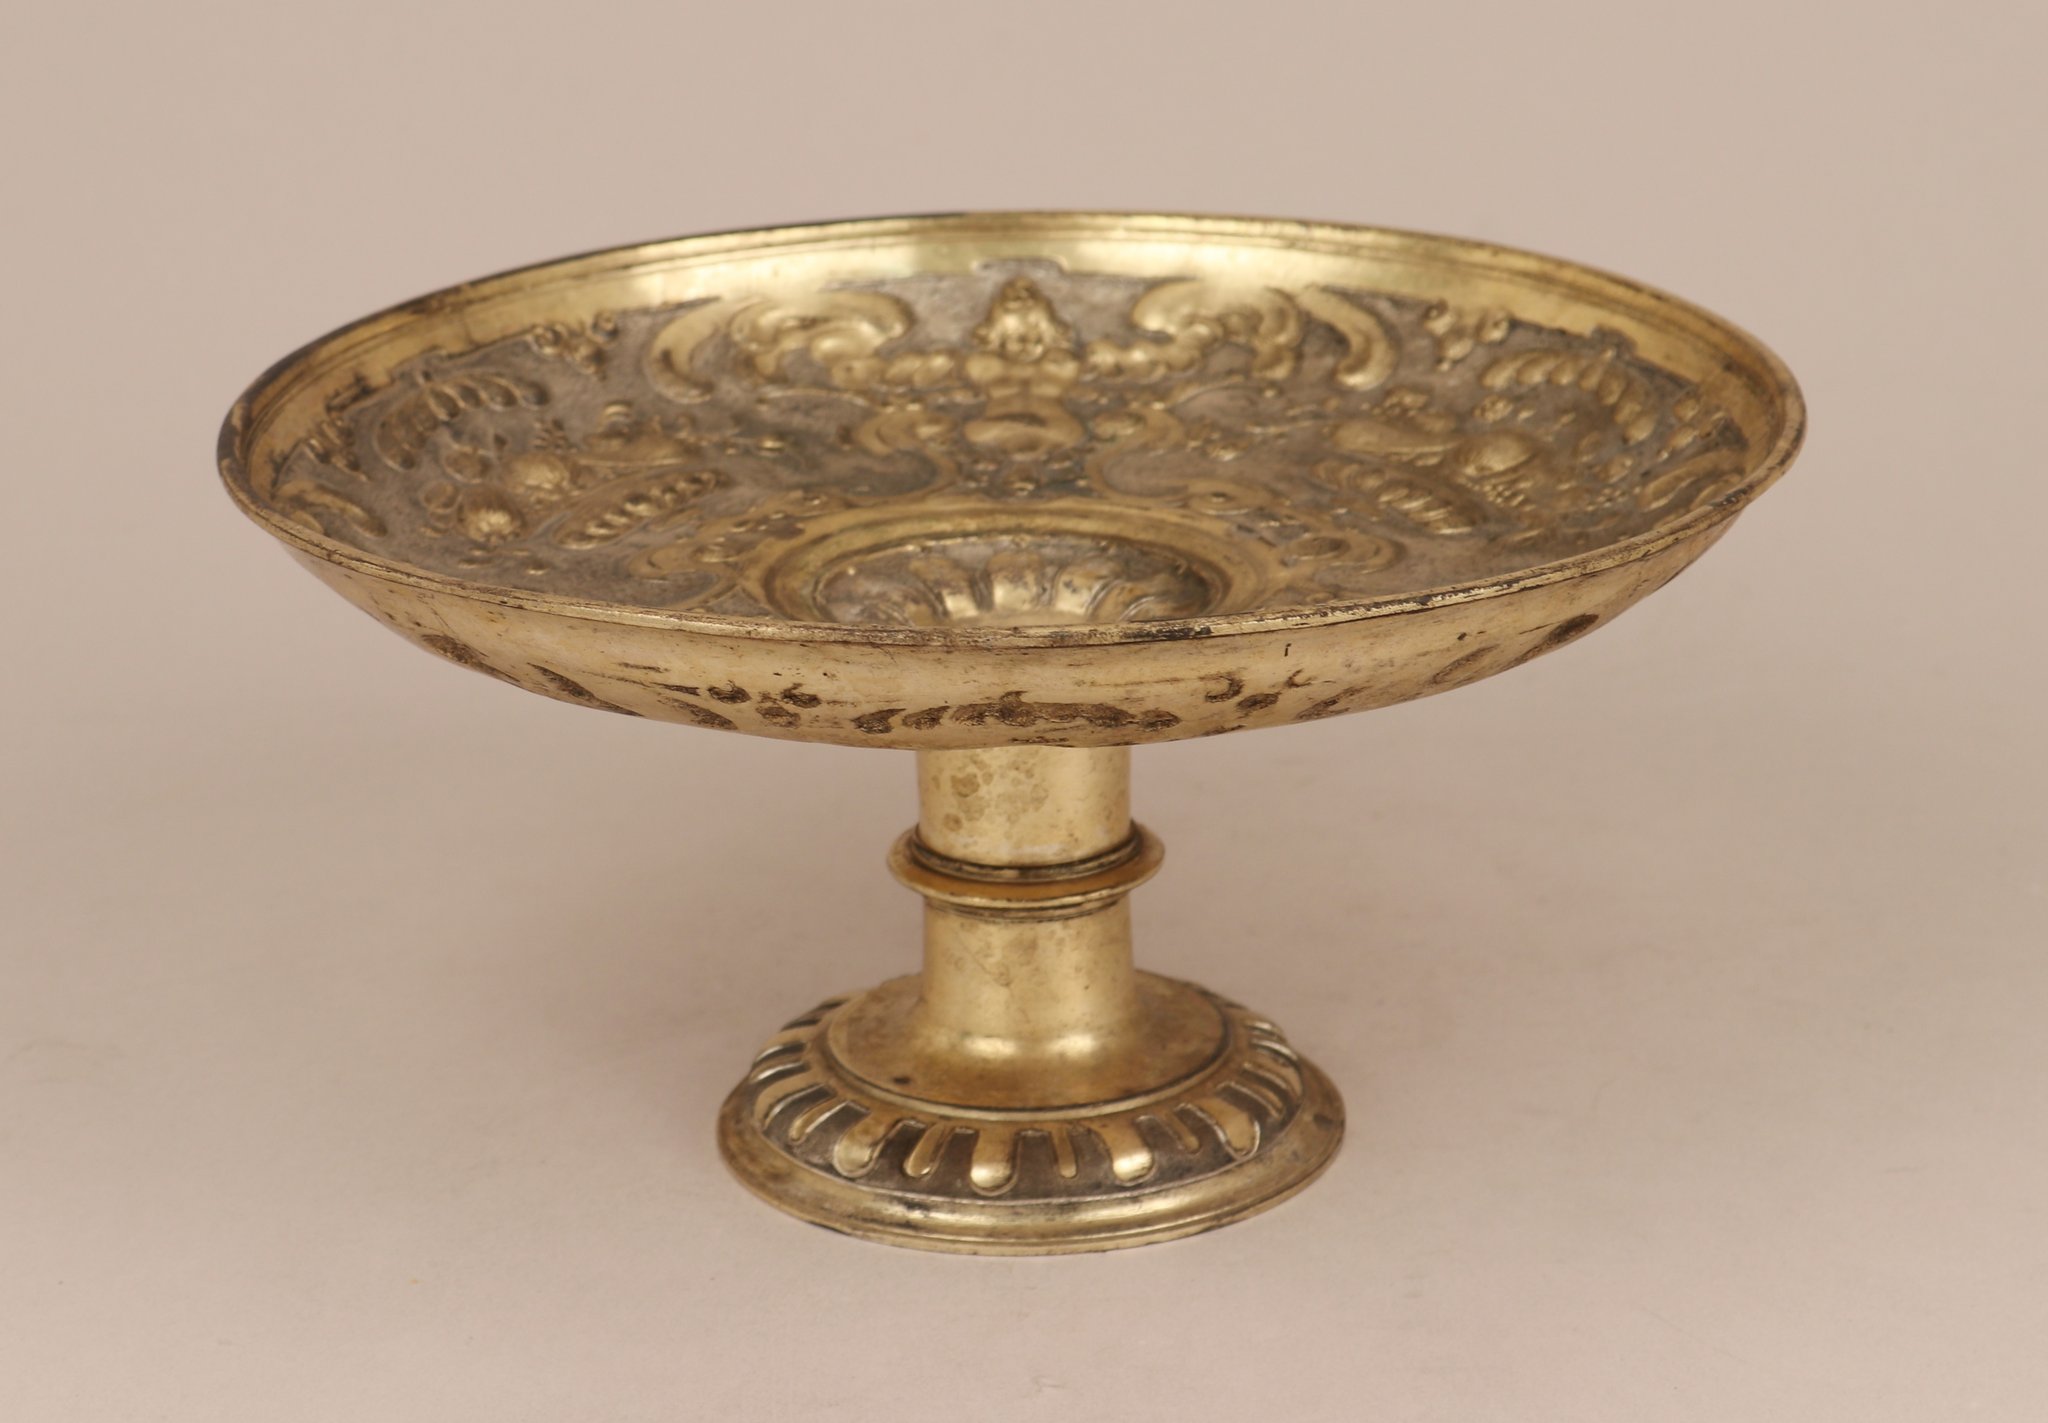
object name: tazza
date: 1801-1900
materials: gilt, metal, silver